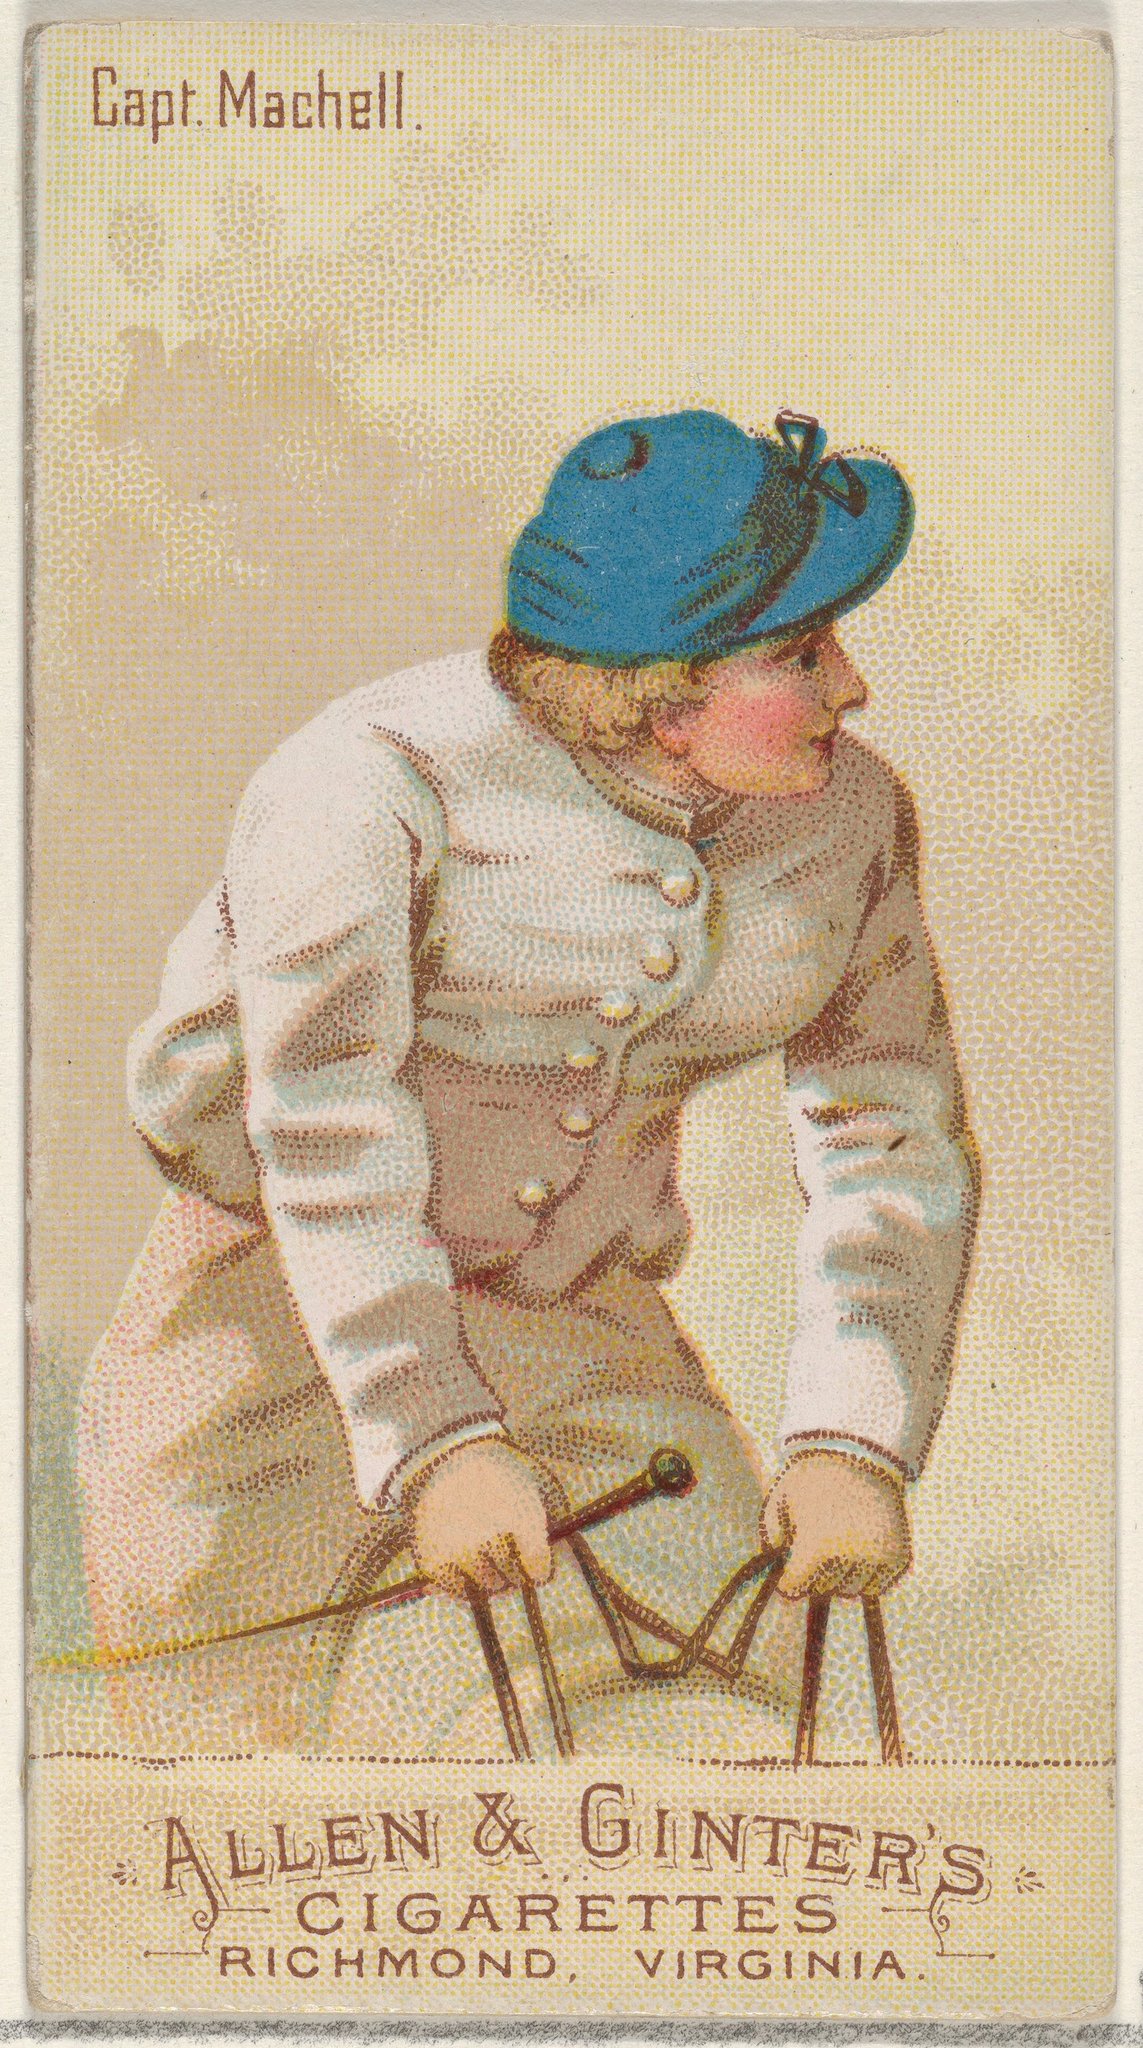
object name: print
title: Captain Machell, from the Racing Colors of the World series (N22b) for Allen & Ginter Cigarettes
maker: allen & ginter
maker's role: publisher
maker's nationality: american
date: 1888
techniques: color lithograph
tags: men,profiles,jockeys